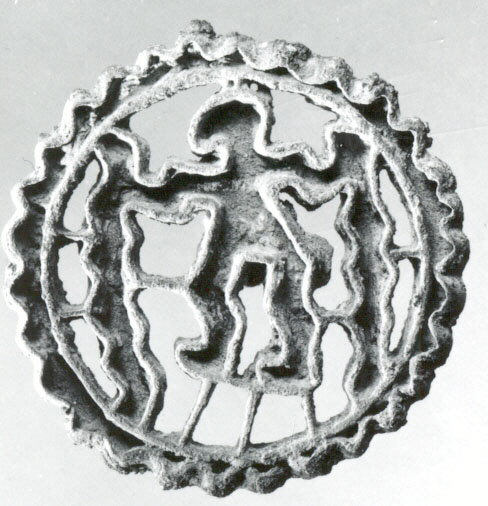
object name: stamp seal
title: Openwork stamp seal: figure holding snakes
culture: bactria-margiana archaeological complex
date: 2333-1668 BCE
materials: copper alloy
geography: bactria-margiana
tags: snakes